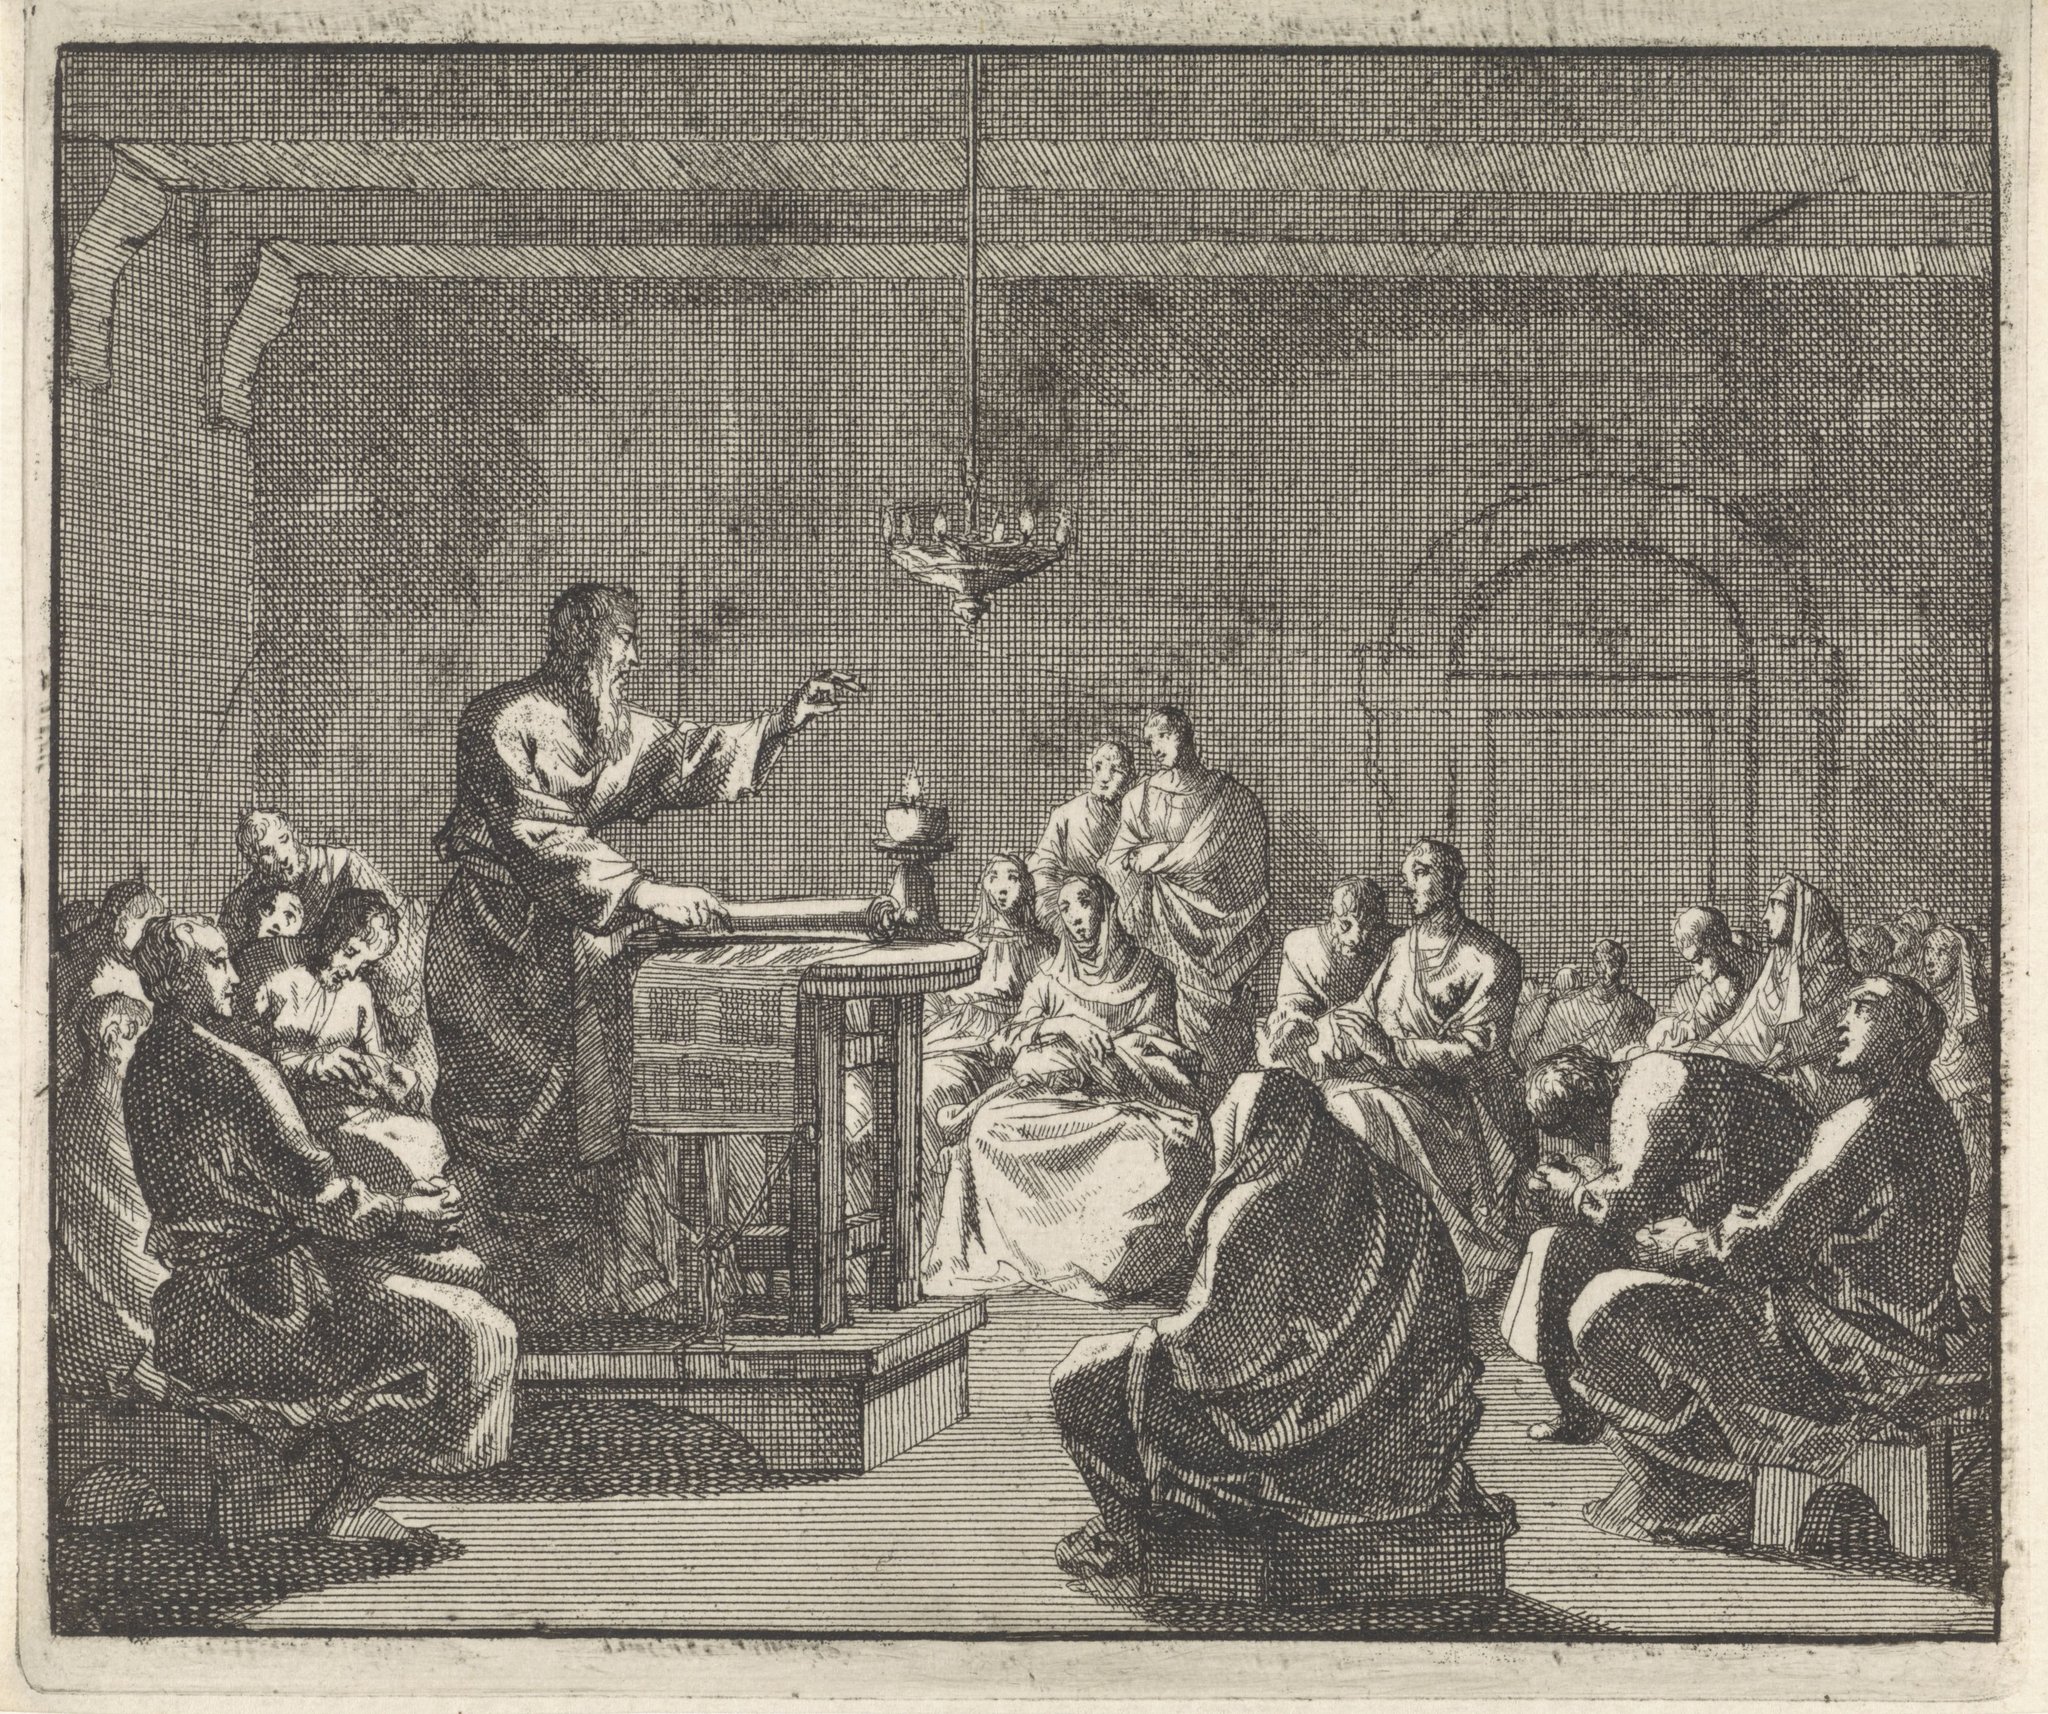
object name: print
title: Vroeg-christelijke gemeenschap luistert naar een preek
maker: jan luyken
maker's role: draughtsman, print maker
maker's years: 1649-1712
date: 1700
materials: paper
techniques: etching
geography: amsterdam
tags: the early christian churches, e.g. armenians, copts, syrians, preaching (in general)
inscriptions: collector's mark: Lugt 2228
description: Proefdruk van een boekillustratie voor Arnold, Godfried. Waare afbeelding der eerste christenen. Amsterdam: Jacobus van Hardenberg, Barent Visscher en Jacobus van Nieuweveen, 1700, dl. 1.